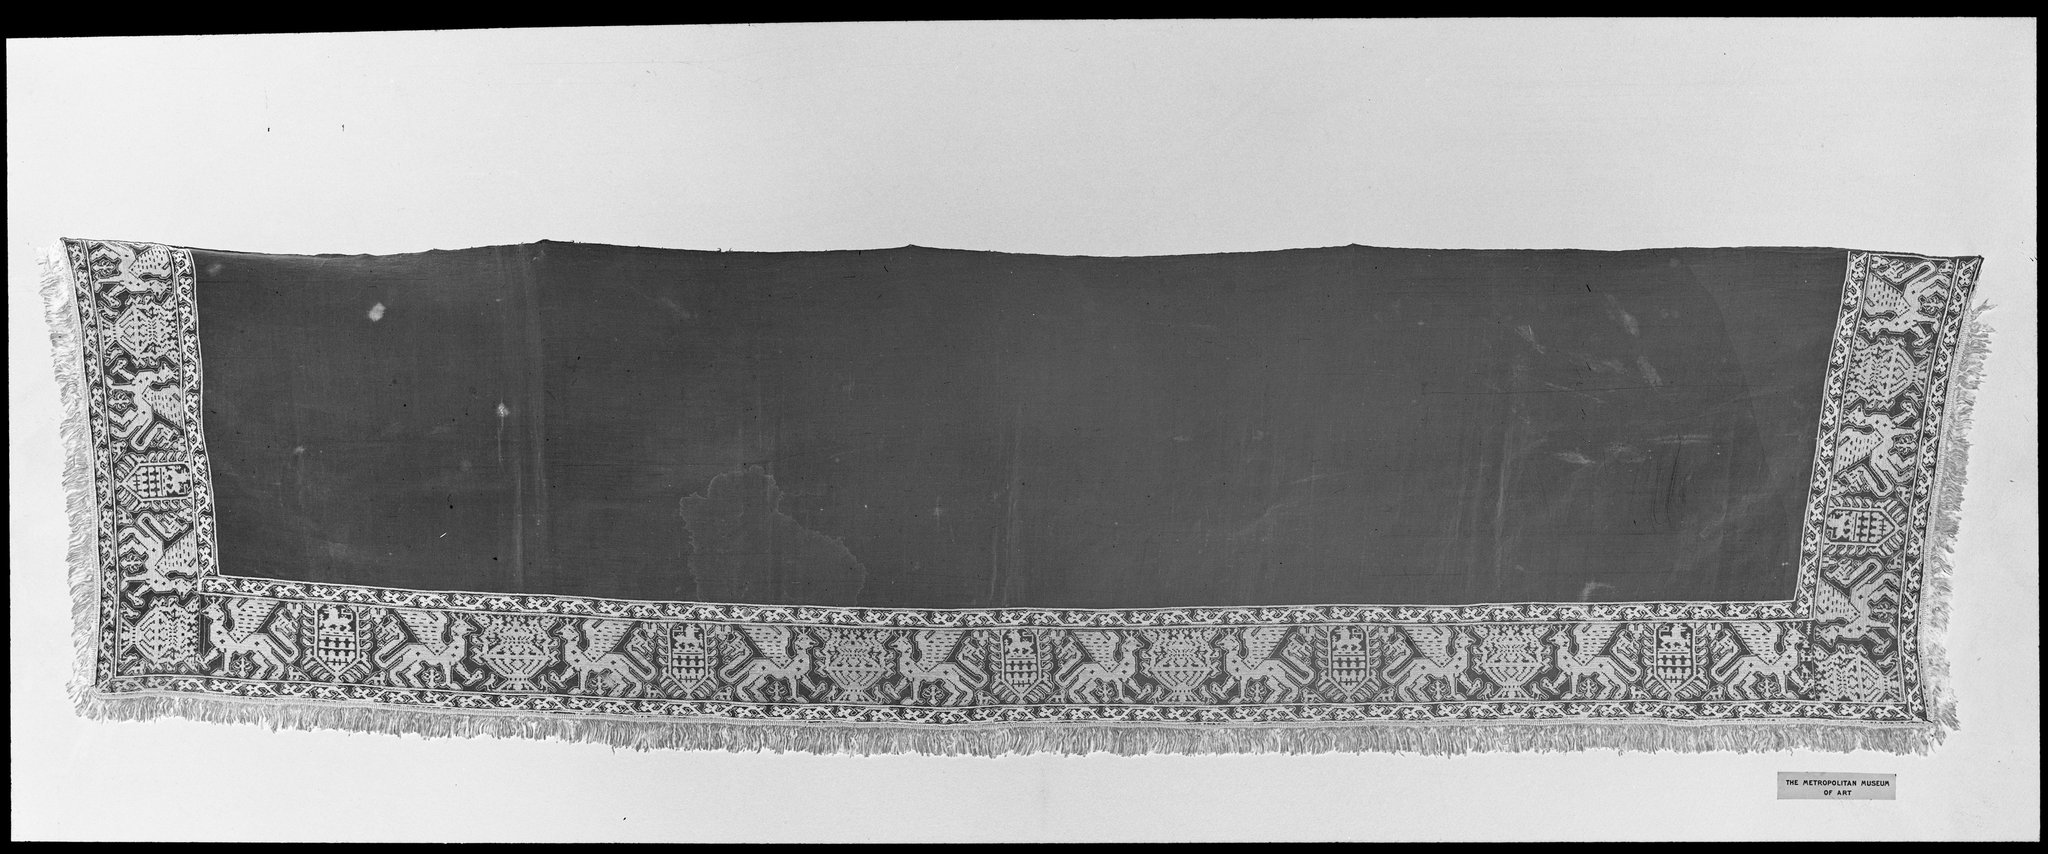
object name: valance or altar frontal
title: Valance or frontal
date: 1701-1800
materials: linen, silk